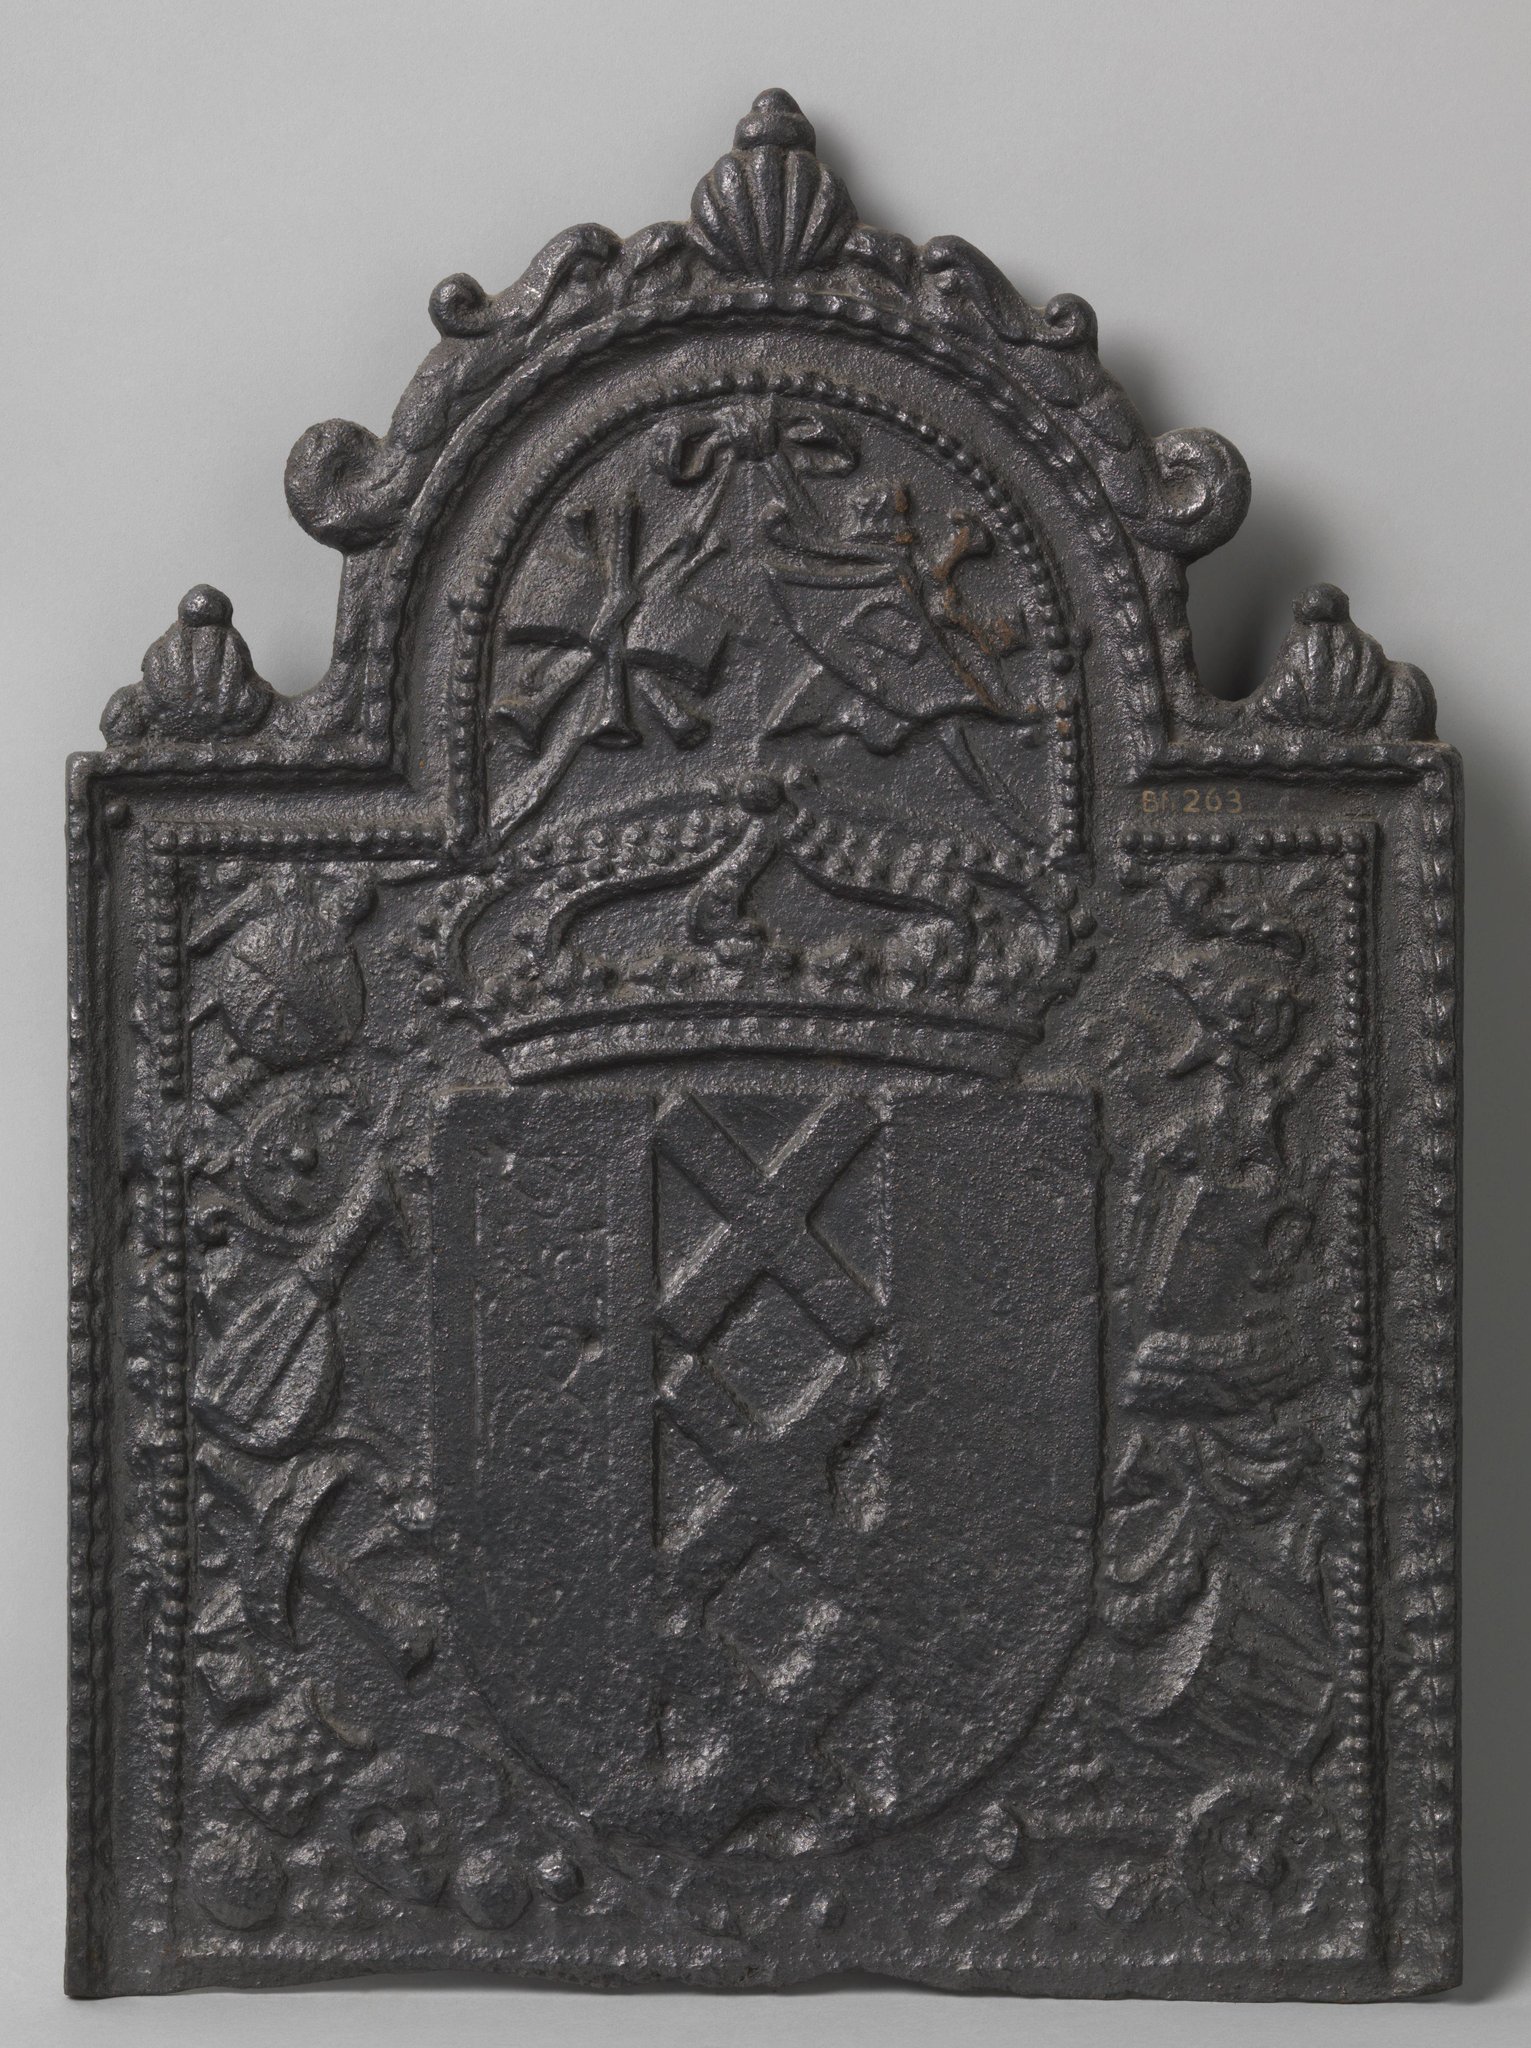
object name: fireback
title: Haardplaat met het stadswapen van Amsterdam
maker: Anonymous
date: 1600-1700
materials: iron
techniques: casting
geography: germany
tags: amsterdam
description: Haardplaat van gietijzer, met halfronde bovenzijde. In het midden is het gekroonde wapenschild van de stad Amsterdam, met aan weerszijden festoenen met muziekinstrumenten. Het tafereel wordt omlijst door een parelrand en een geribbelde buitenrand. Het geheel wordt bekroond met drie schelpmotieven, met aan weerszijden een omhoogklimmende dolfijn.